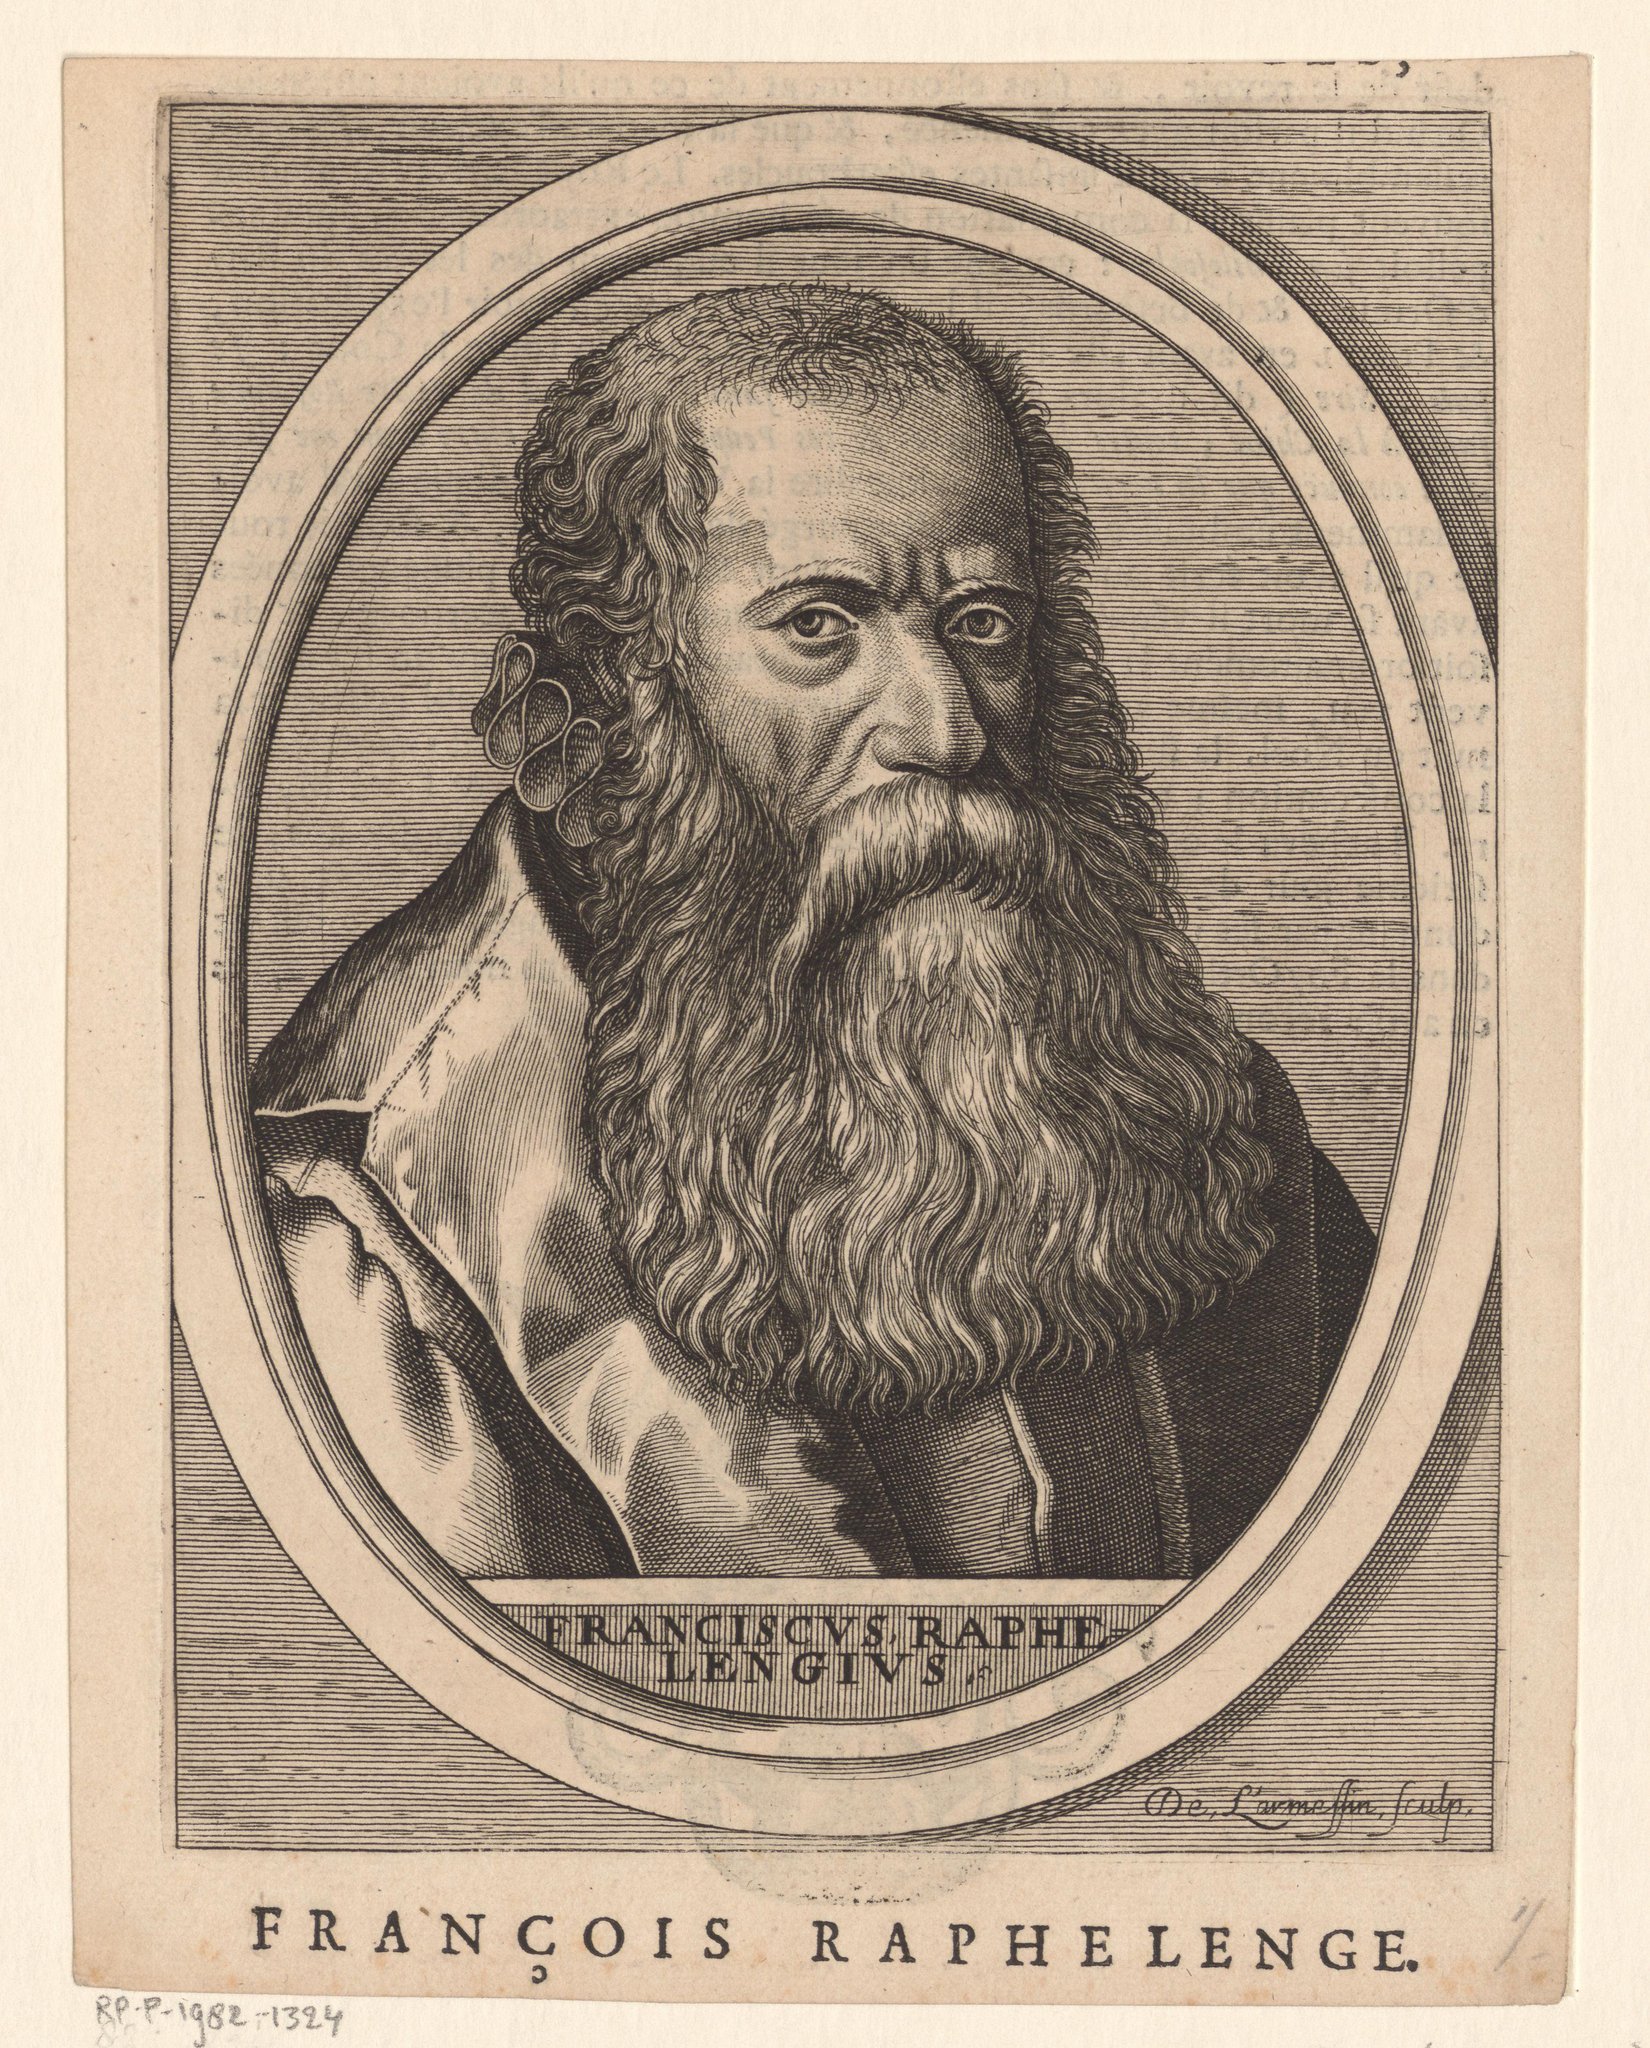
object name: book illustration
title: Portret van Franciscus Raphelengius I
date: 1682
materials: paper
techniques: engraving, letterpress printing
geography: brussels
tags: france, leiden, franciscus raphelengius (i), historical persons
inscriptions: collector's mark: Lugt 2228, collector's mark: Lugt 2760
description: Prent uit: Bullart, Isaac. Académie des Sciences et Arts contenant les vies et éloges his. des hommes illustres qui ont excellé en ces professions depuis environ quatre siècles. Brussel: François Foppens, 1682.